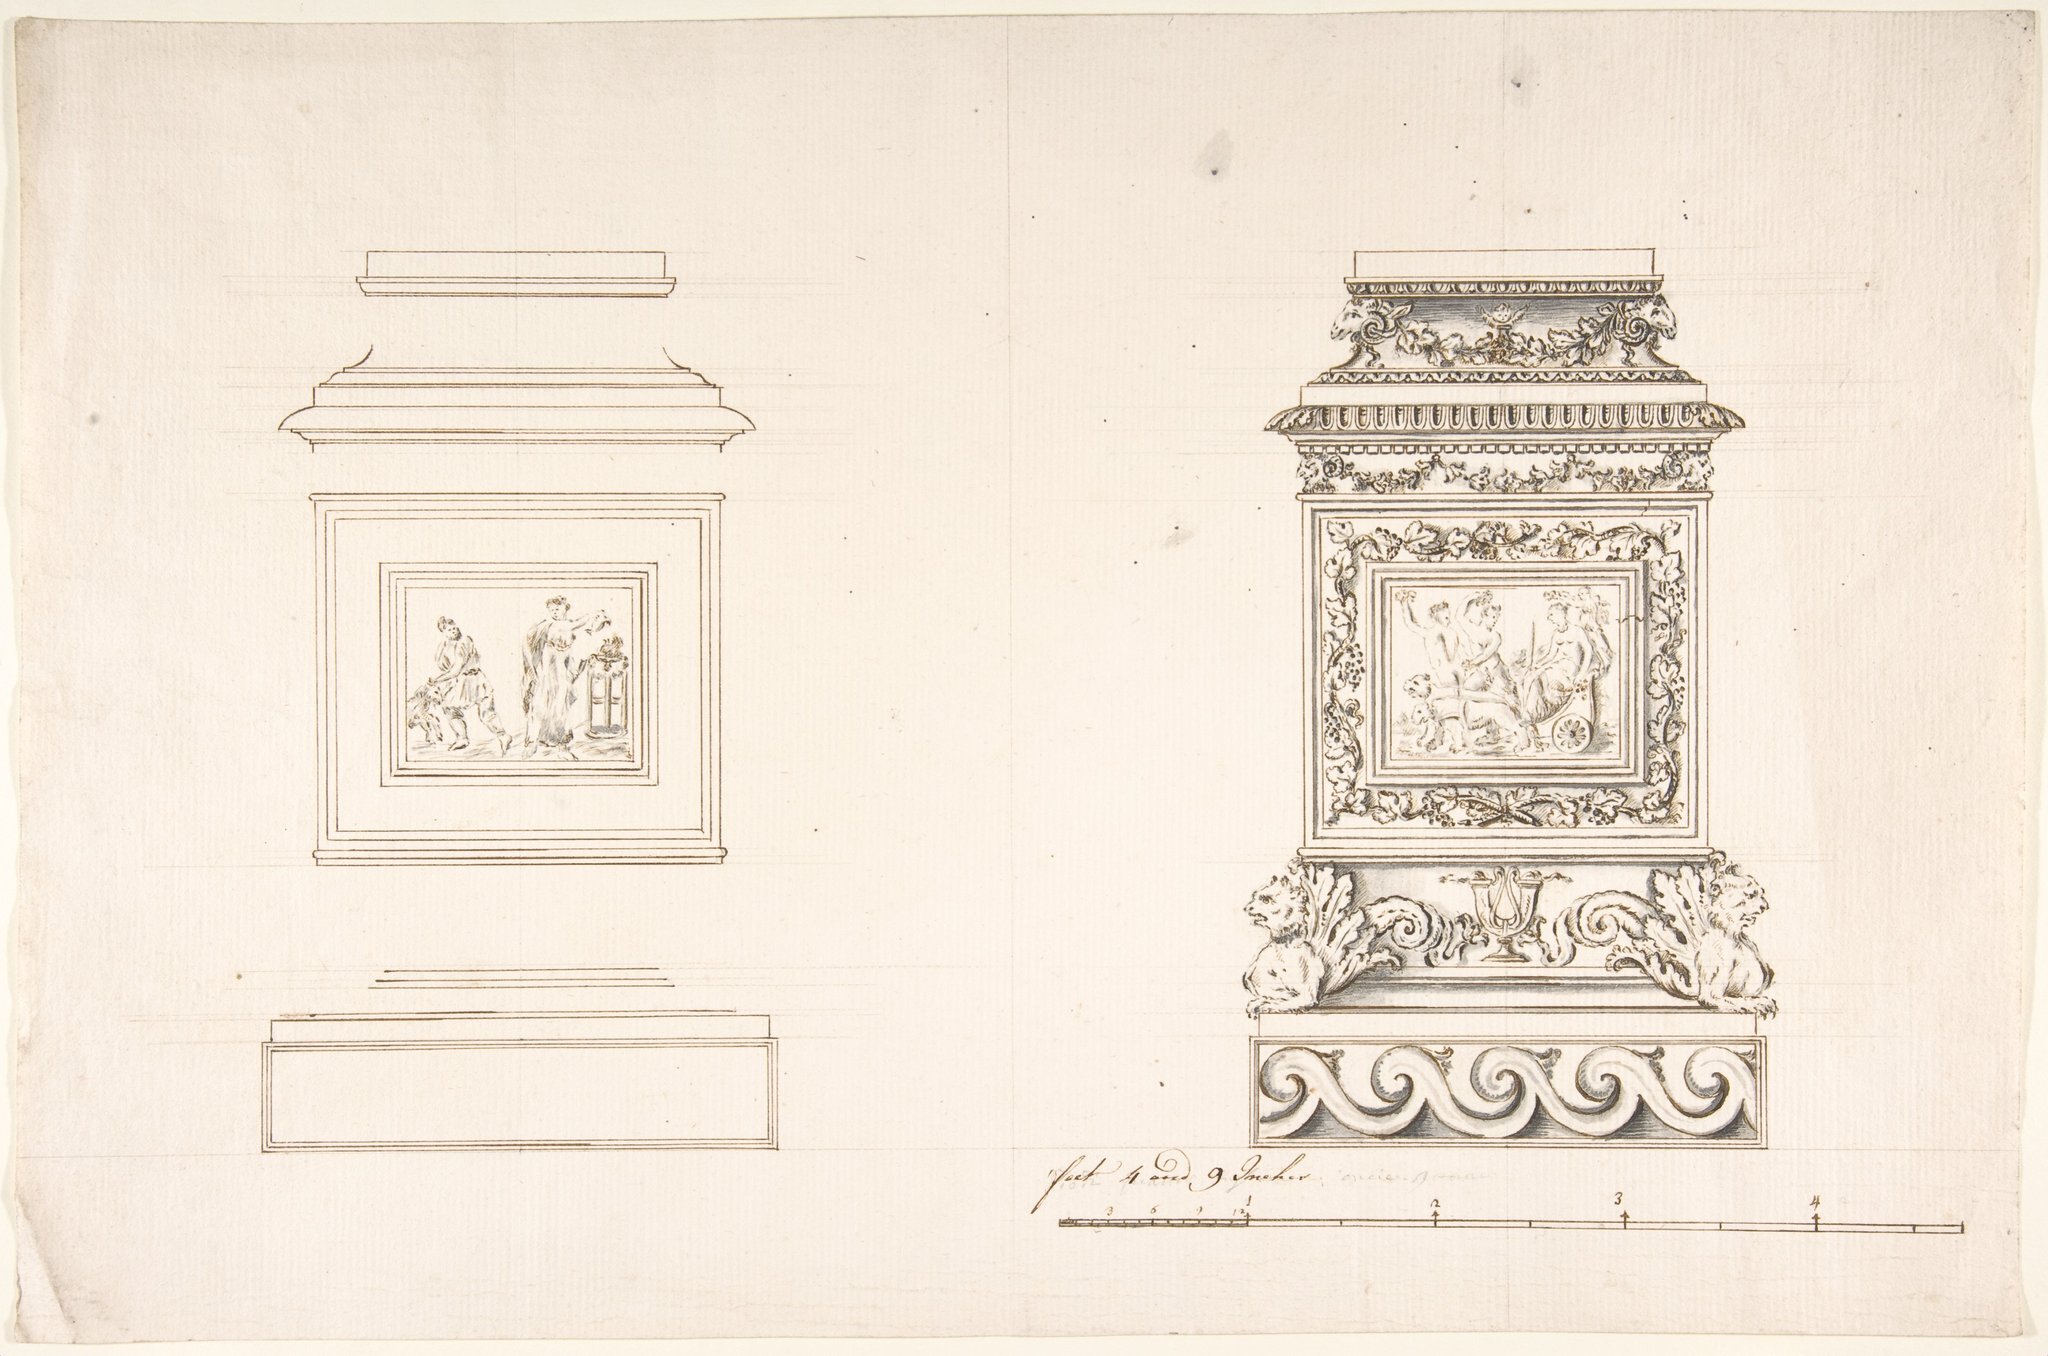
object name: drawing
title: Two pedestals with classical scenes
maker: anonymous, british, 18th century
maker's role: artist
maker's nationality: british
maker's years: 1700-1800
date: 1701-1800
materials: ink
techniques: brush, pen, wash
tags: architecture